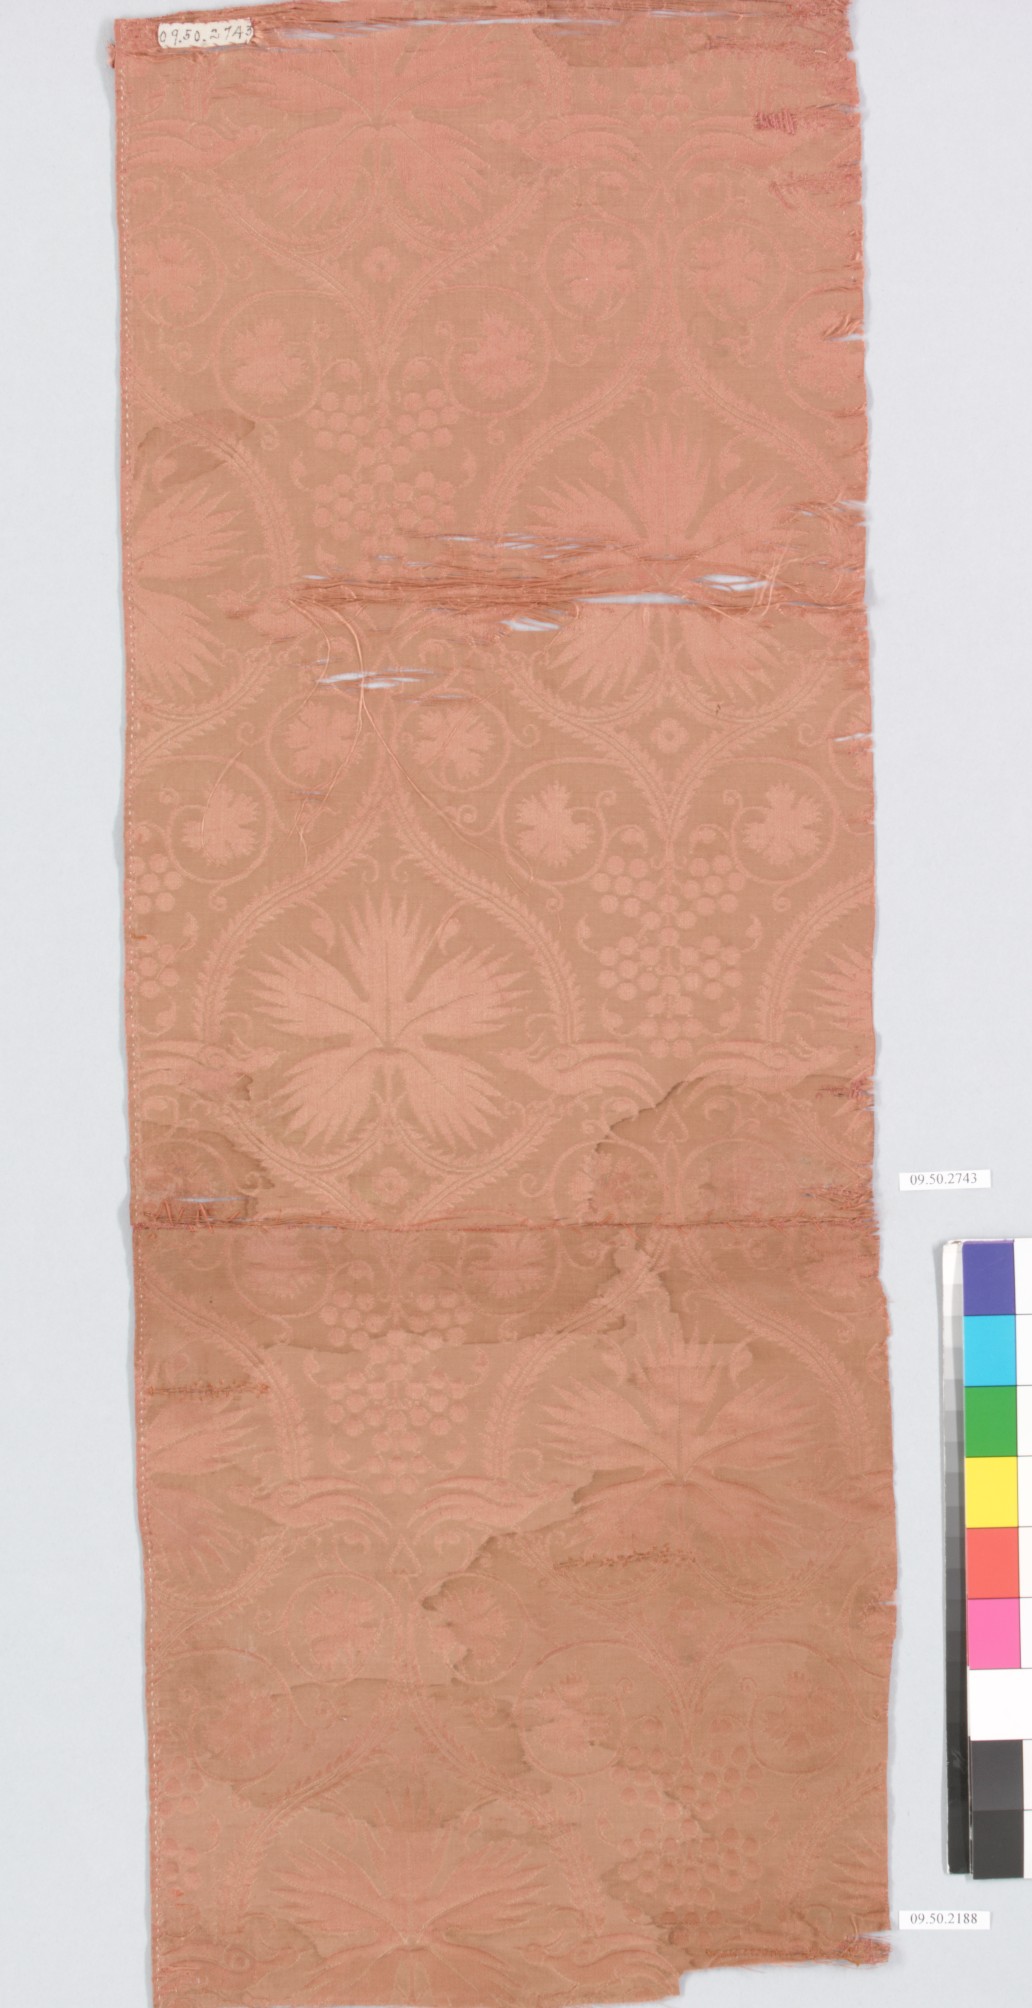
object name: piece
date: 1801-1900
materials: silk